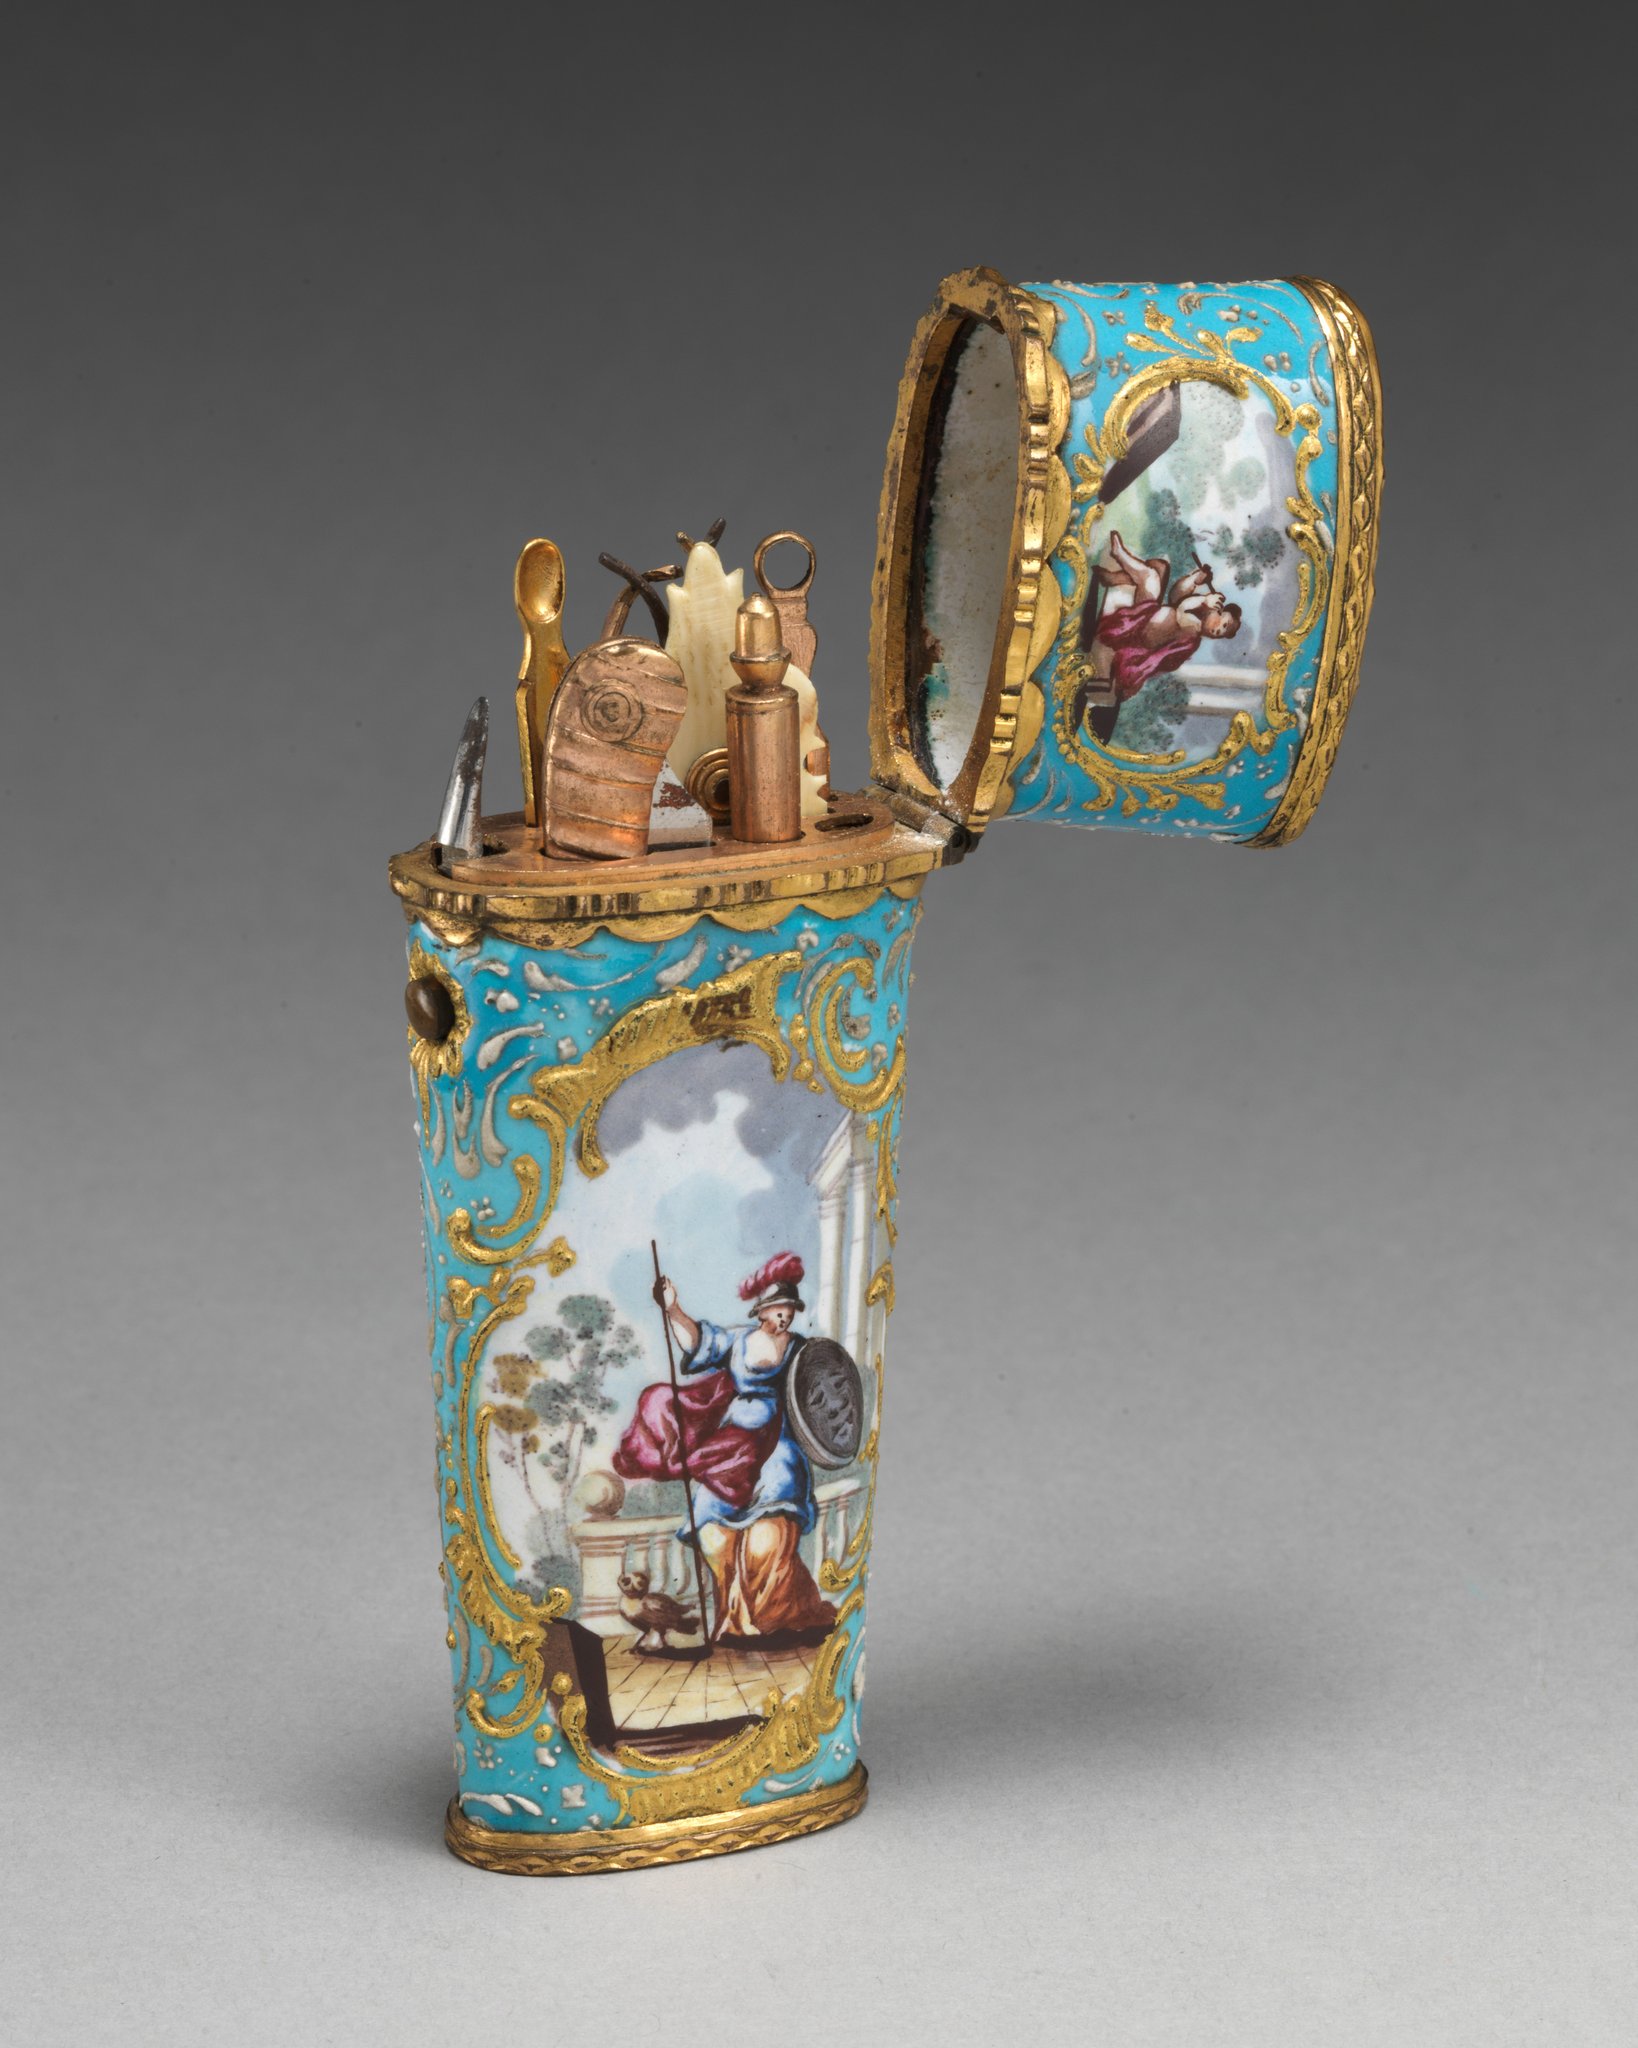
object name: étui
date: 1765-1770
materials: copper, enamel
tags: birds,men